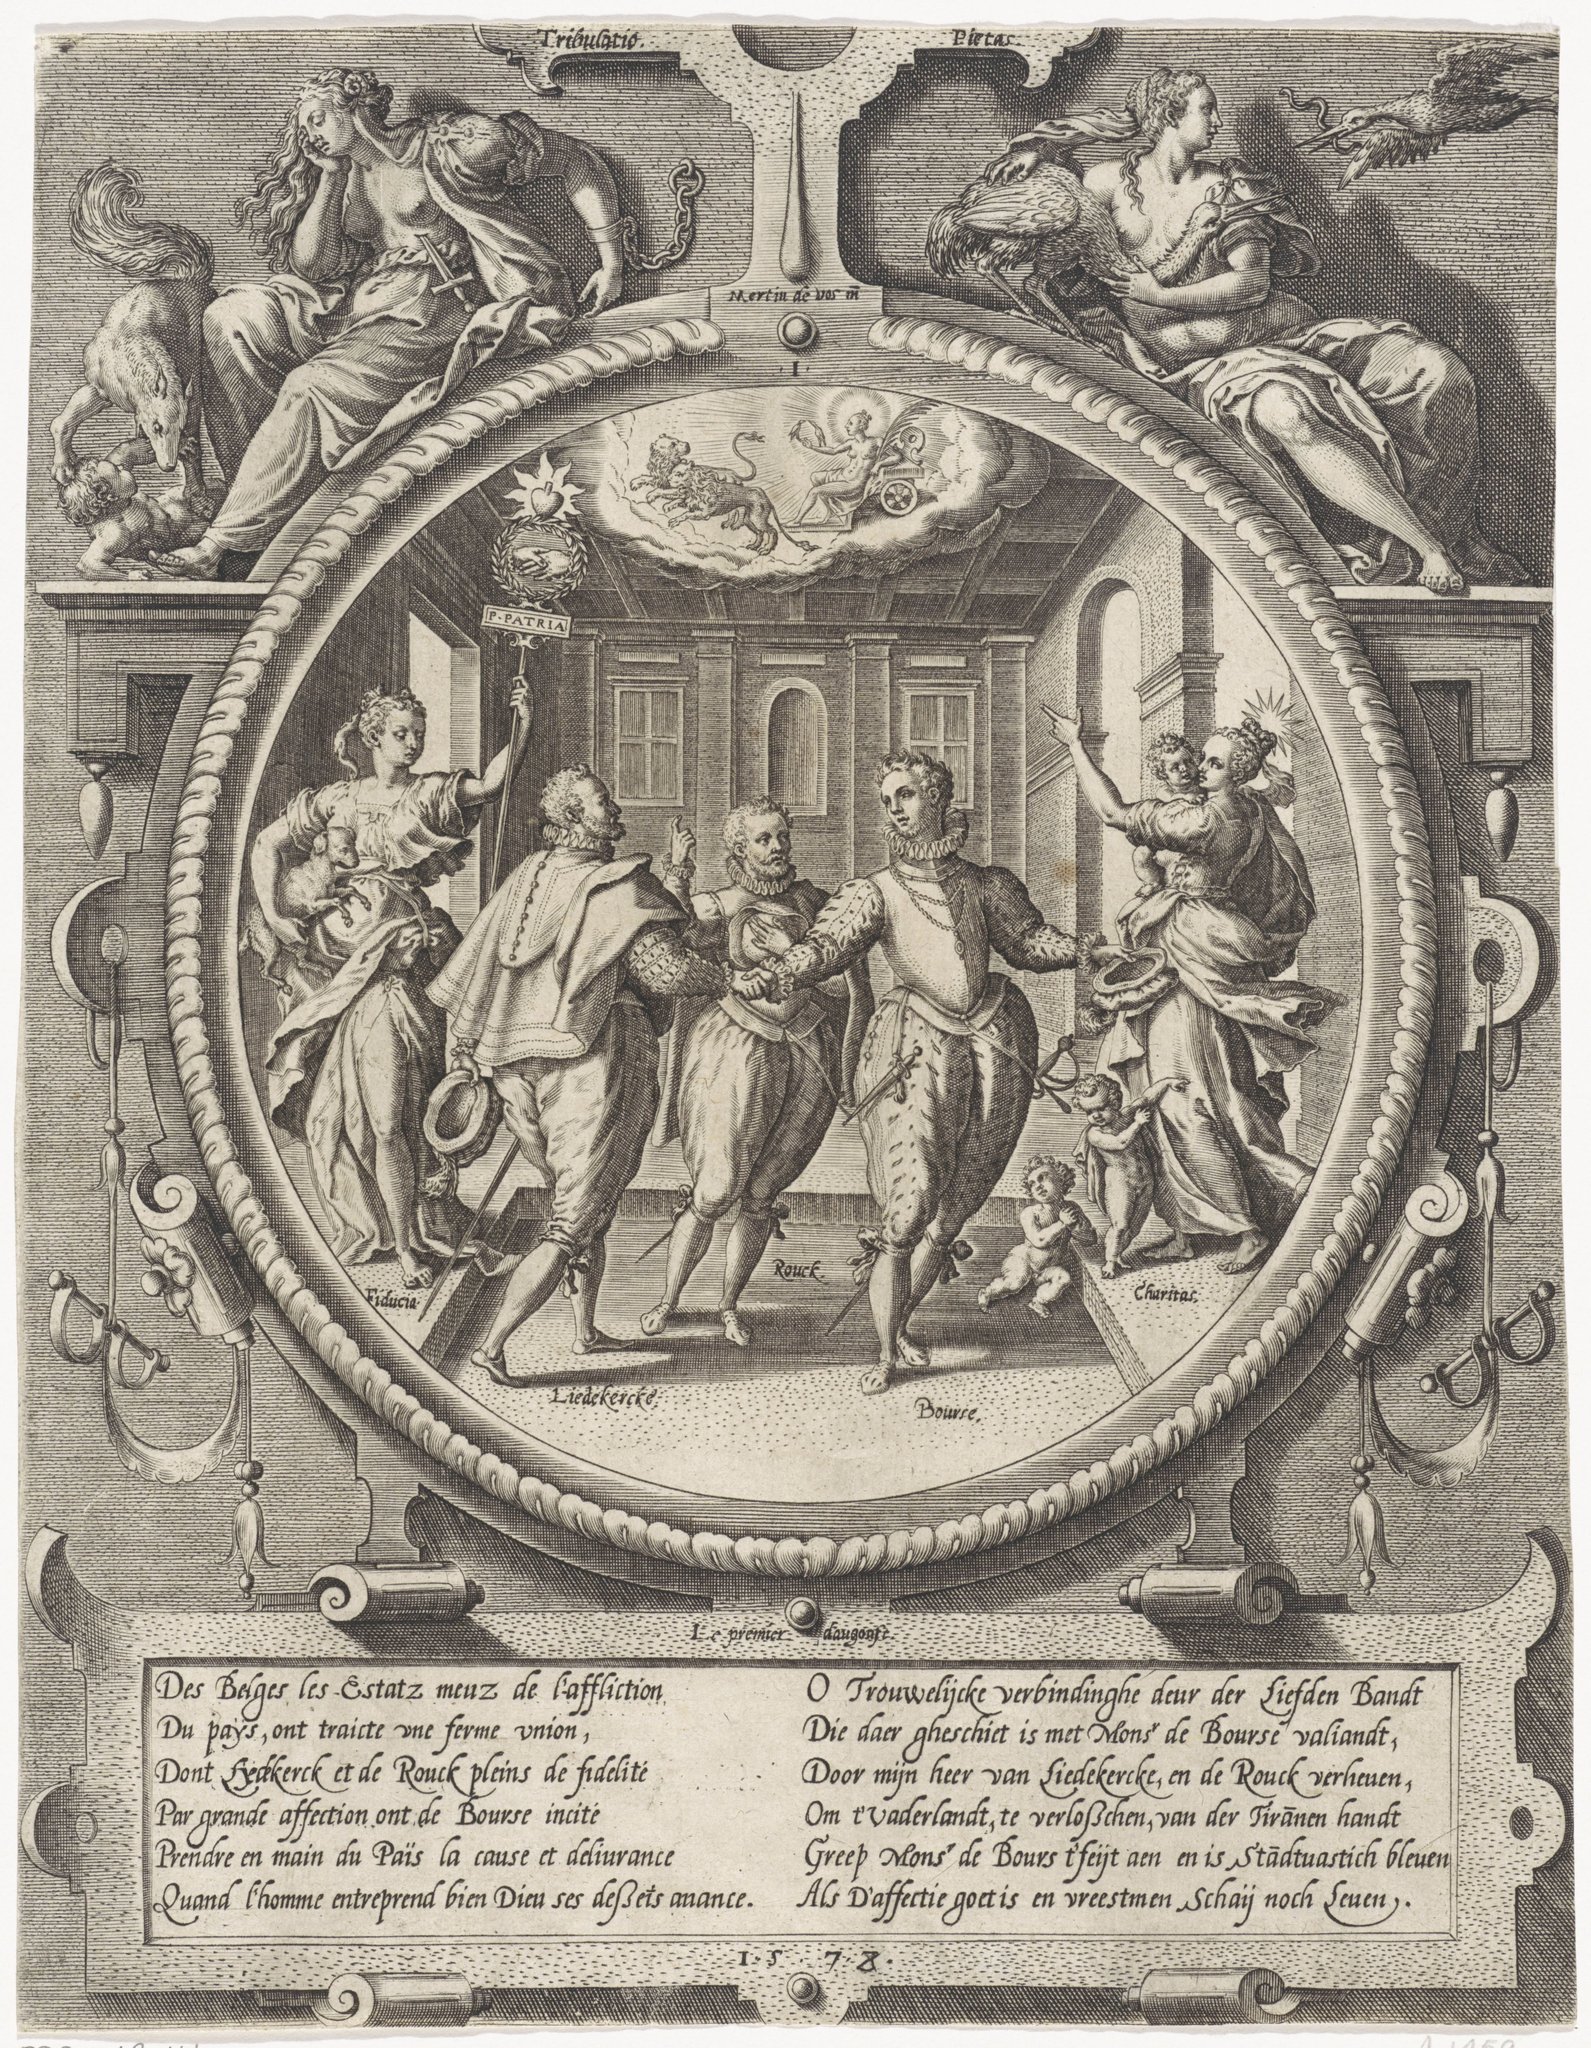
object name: propagandaprent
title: Medaillons met de verovering van de citadel van Antwerpen in 1577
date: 1578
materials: paper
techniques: engraving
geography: antwerp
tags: charity, 'caritas'; 'carità' (ripa) ~ one of the three theological virtues, torment; 'tribulatione' (ripa), fidelity; 'fedeltà' (ripa), triumph of venus; 'carro di venere' (ripa), piety, 'pietas', 'timor dei' ~ the three theological virtues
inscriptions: collector's mark: Lugt 2228, collector's mark: Lugt 2760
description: Het verbond tussen Liedekercke, Roeck en Bourse, om de Citadel van Antwerpen te veroveren, 1 augustus 1577. Interieur waarin de drie mannen een eed afleggen. Links Trouw (Fiducia) en Liefde (Charitas), in de wolken de triomfwagen van Venus. Voorstelling in een rond medaillon met ornamentale allegorische omlijsting met bovenaan de zittende vrouwelijke personificaties van Kwelling (Tribulatio) en Vroomheid (Pietas). Onderaan een cartouche met 2 verzen van elk 6 regels in het Frans en Nederlands.